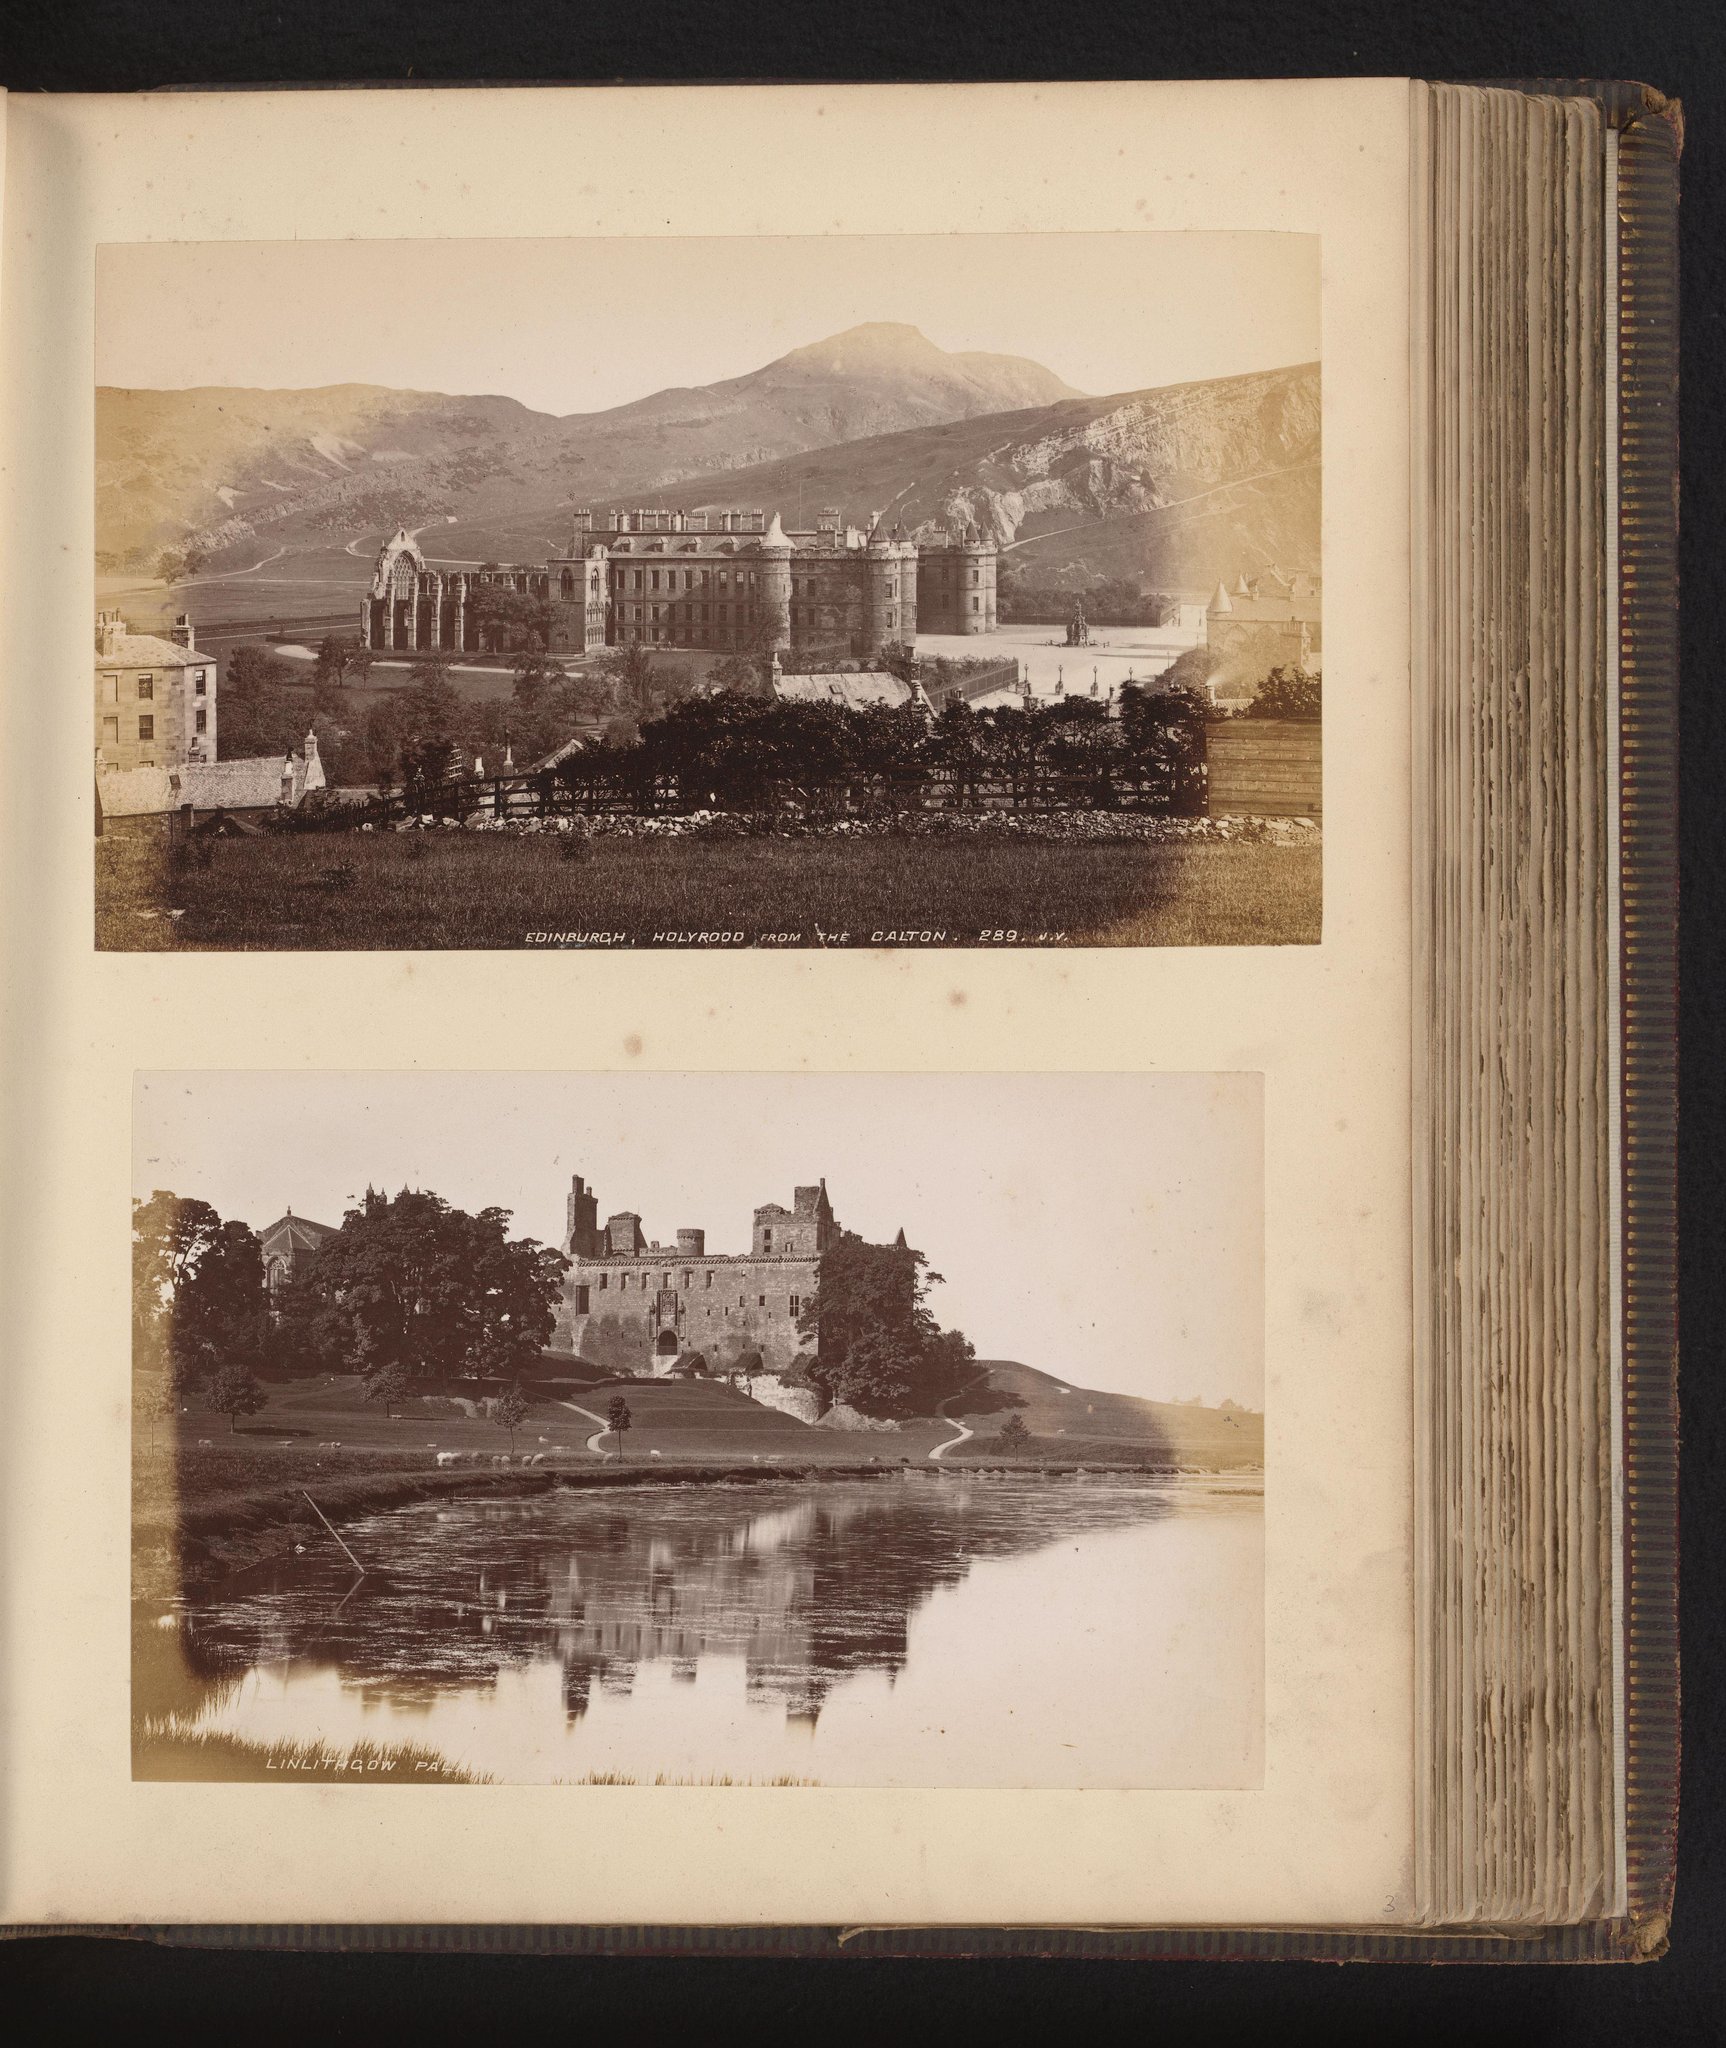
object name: album leaf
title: Gezicht op Holyrood en Linlithgow Palace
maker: Anonymous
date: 1875-1885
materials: photographic support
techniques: albumen print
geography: edinburgh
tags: landscapes with waters, waterscapes, seascapes (in the temperate zone), abbey, monastery, convent ~ roman catholic church, palace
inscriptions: number: ‘289, J.V.’